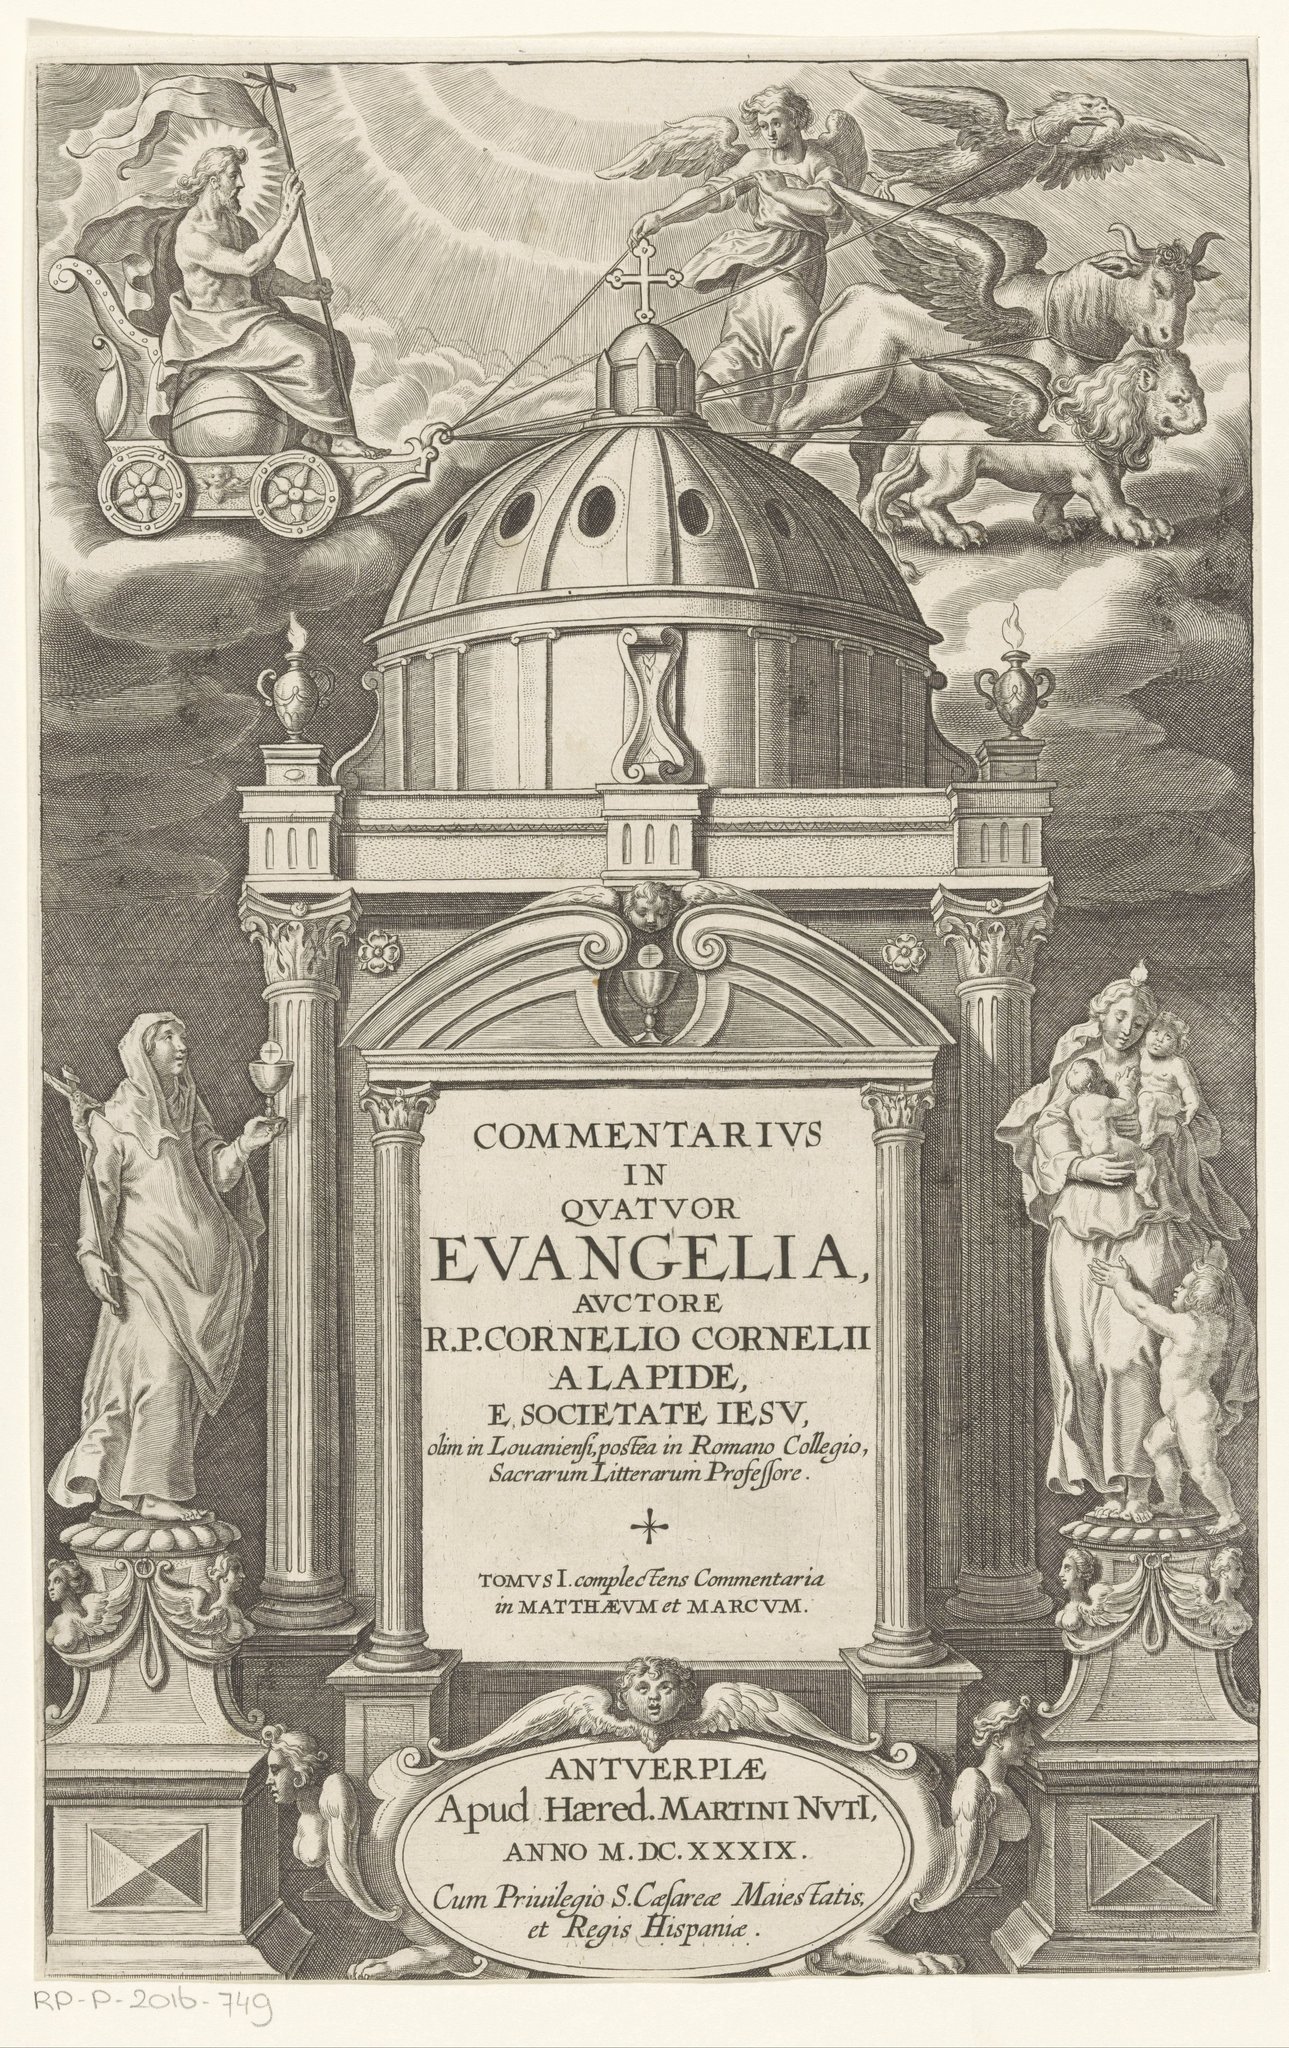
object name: print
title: Geloof, Liefde en Christus in triomfwagen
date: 1639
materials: paper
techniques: engraving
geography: antwerp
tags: charity, 'caritas'; 'carità' (ripa) ~ one of the three theological virtues, faith, 'fides'; 'fede', 'fede catholica', 'fede christiana', 'fede christiana catholica' (ripa) ~ one of the three theological virtues, triumphant christ, e.g. on triumphal chariot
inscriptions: collector's mark: Lugt 2228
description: Een koepelgebouw met titel geflankeerd door de deugden Geloof met kruis en kerk met hostie en Liefde met drie kinderen. Daarboven in wolken wordt Christus in een triomfwagen voortgetrokken door de vier wezens.